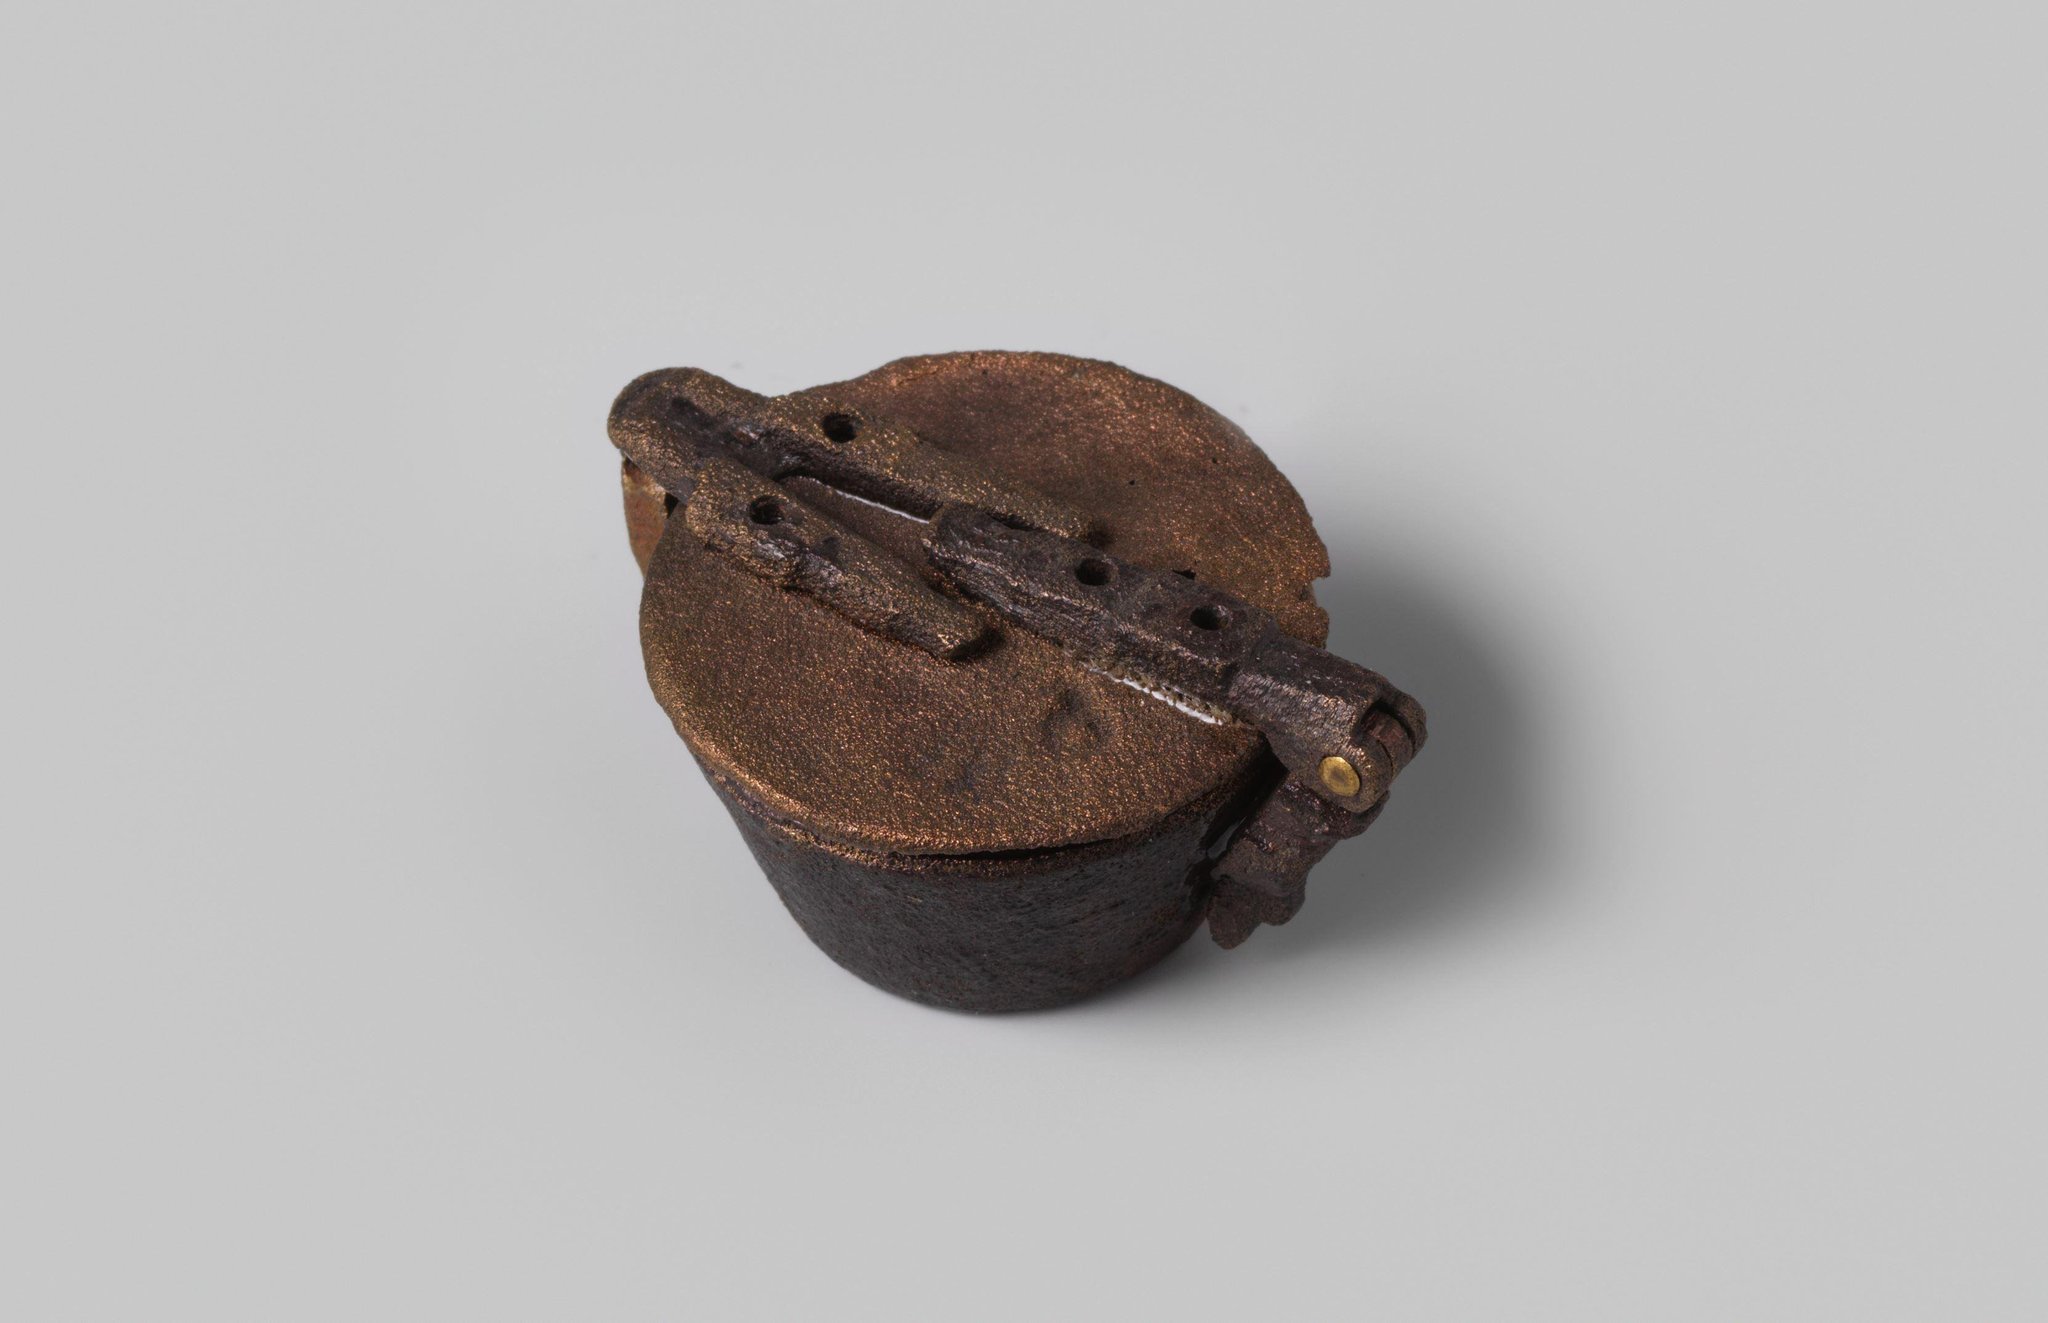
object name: sluitgewicht, pijlgewicht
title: Nested cup weight from the wreck of the Dutch East India ship Hollandia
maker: Anonymous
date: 1700-1743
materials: copper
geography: netherlands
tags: verenigde oostindische compagnie, hollandia (schip), annet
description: Weight, cupweight, complete nest; fragm, set of 7 weights, id. NG 1980-27H2775, corroded together, lid missing.